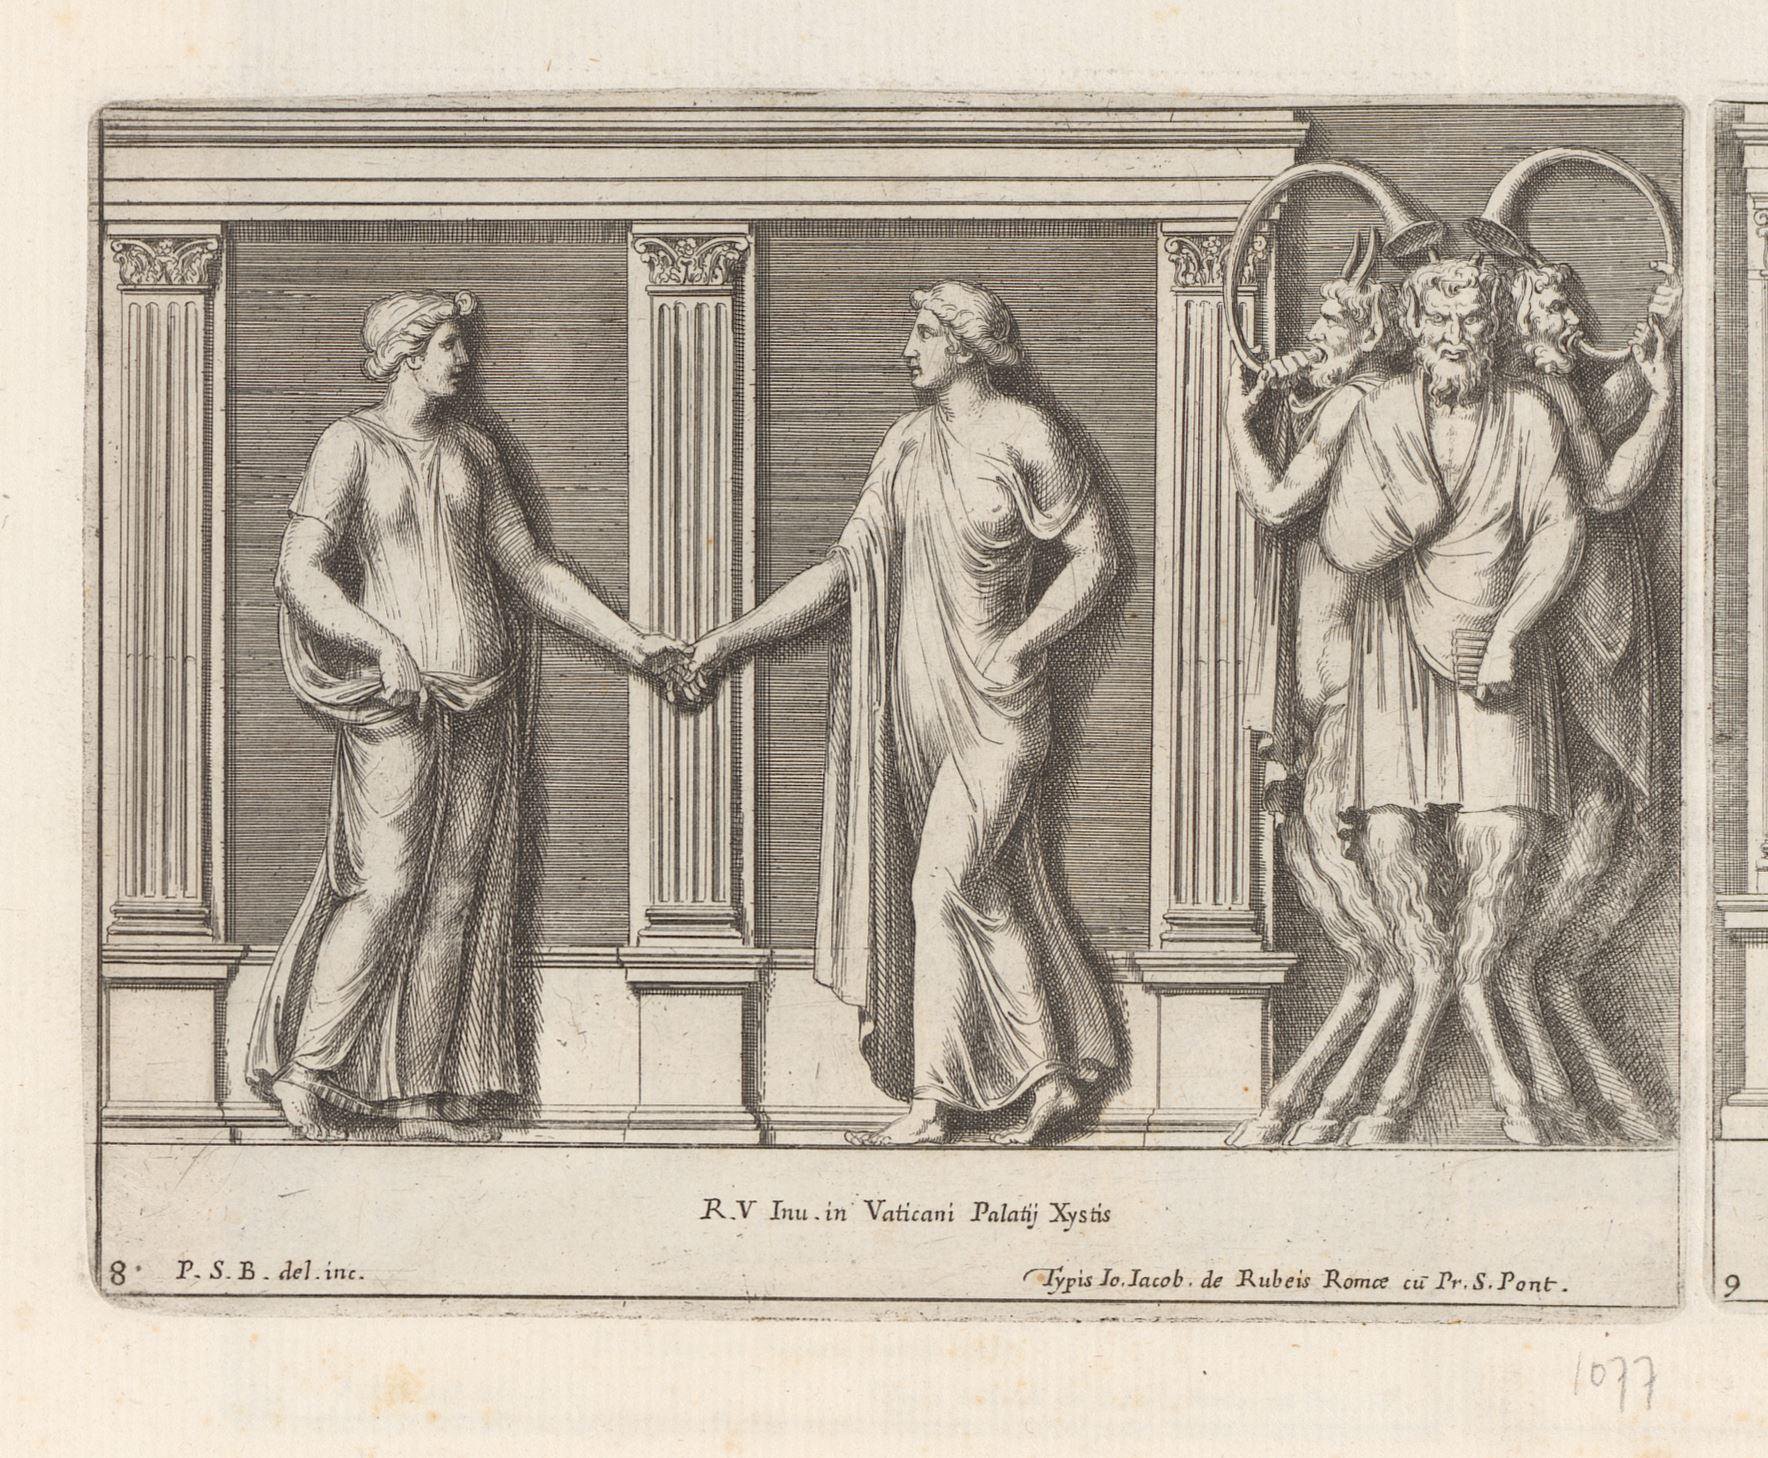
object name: album leaf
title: Twee dansende figuren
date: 1645-1700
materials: paper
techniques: engraving, etching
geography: rome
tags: adult woman, dancing, satyr(s) (in general)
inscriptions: number: ‘40’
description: Twee dansende vrouwenfiguren voor drie pilasters. Rechts drie saters waarvan er twee op trompetten blazen. Prent maakt deel uit van een album.